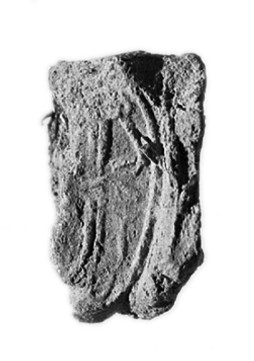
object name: sealing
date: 1981-1640 BCE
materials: mud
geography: egypt